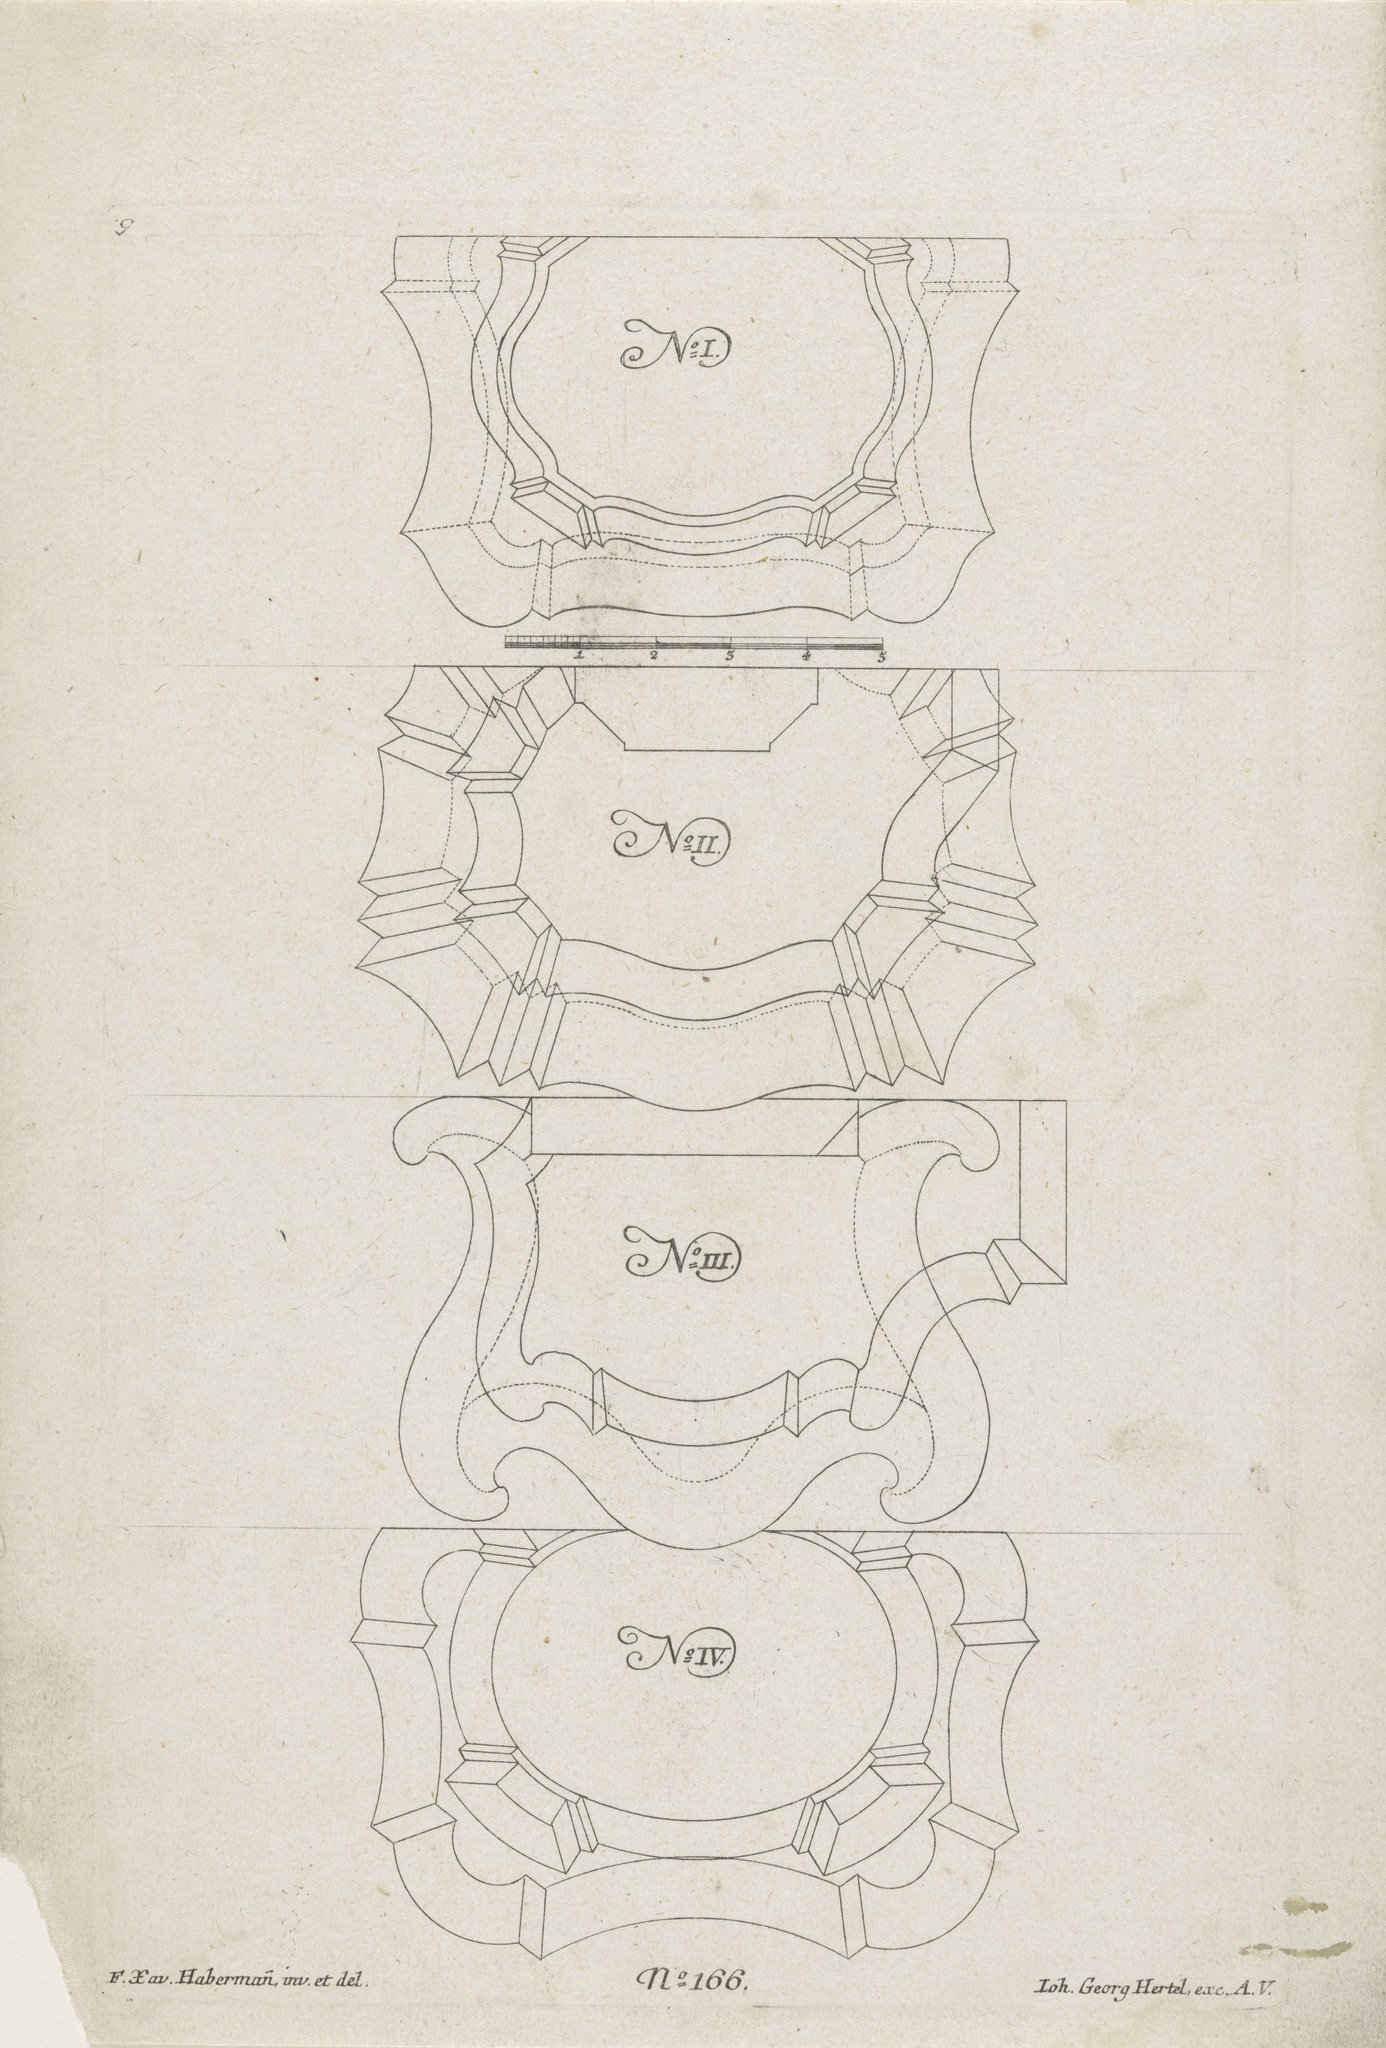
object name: ornament print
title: Plattegronden van preekstoelen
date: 1740-1745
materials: paper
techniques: engraving, etching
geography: augsburg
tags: pulpit, ambo, chancel, architectural design or model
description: Plattegronden van vier preekstoelen. Uitgeversnummer 166.